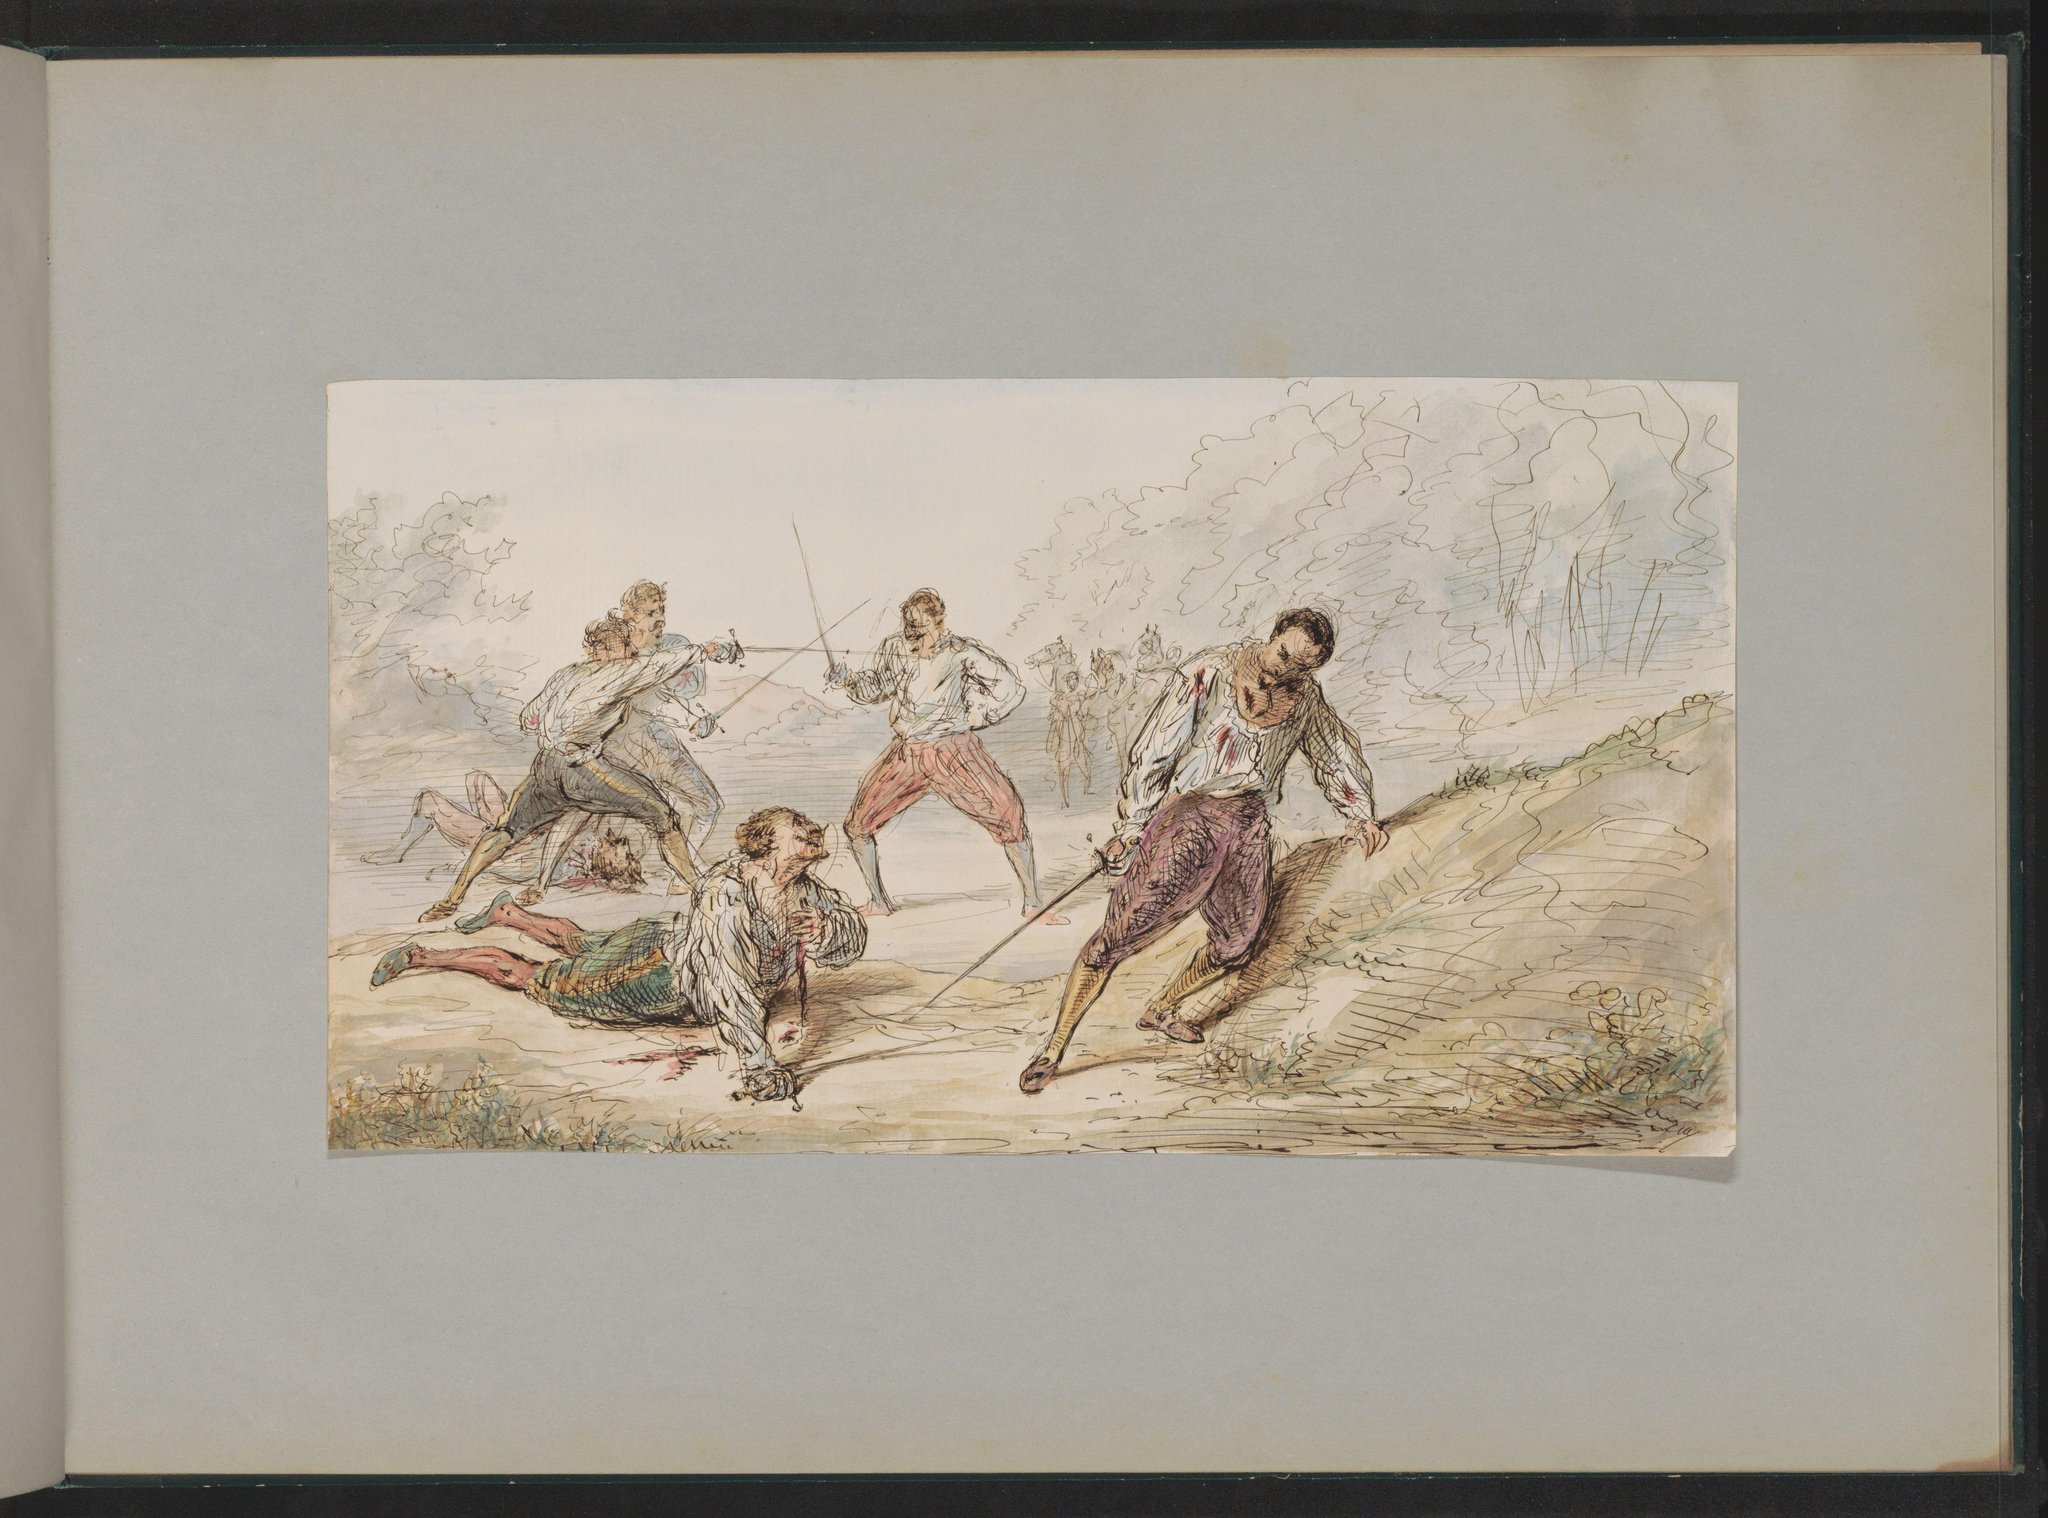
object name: drawing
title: Landschap met duellerende mannen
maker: alexander ver huell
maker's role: draughtsman, print maker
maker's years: 1822-1897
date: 1854-1887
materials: ink, paper, watercolor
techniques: brush, pen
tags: violent death, being killed; being mishandled and maltreated; seeking death, landscapes (+ landscape with figures, staffage), duelling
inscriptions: signature: ‘Avh’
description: Op de voorgrond een groep zwaardvechtende mannen met verschillende wonden op de borst. Tekening op blad 16 van een album met 35 tekeningen.